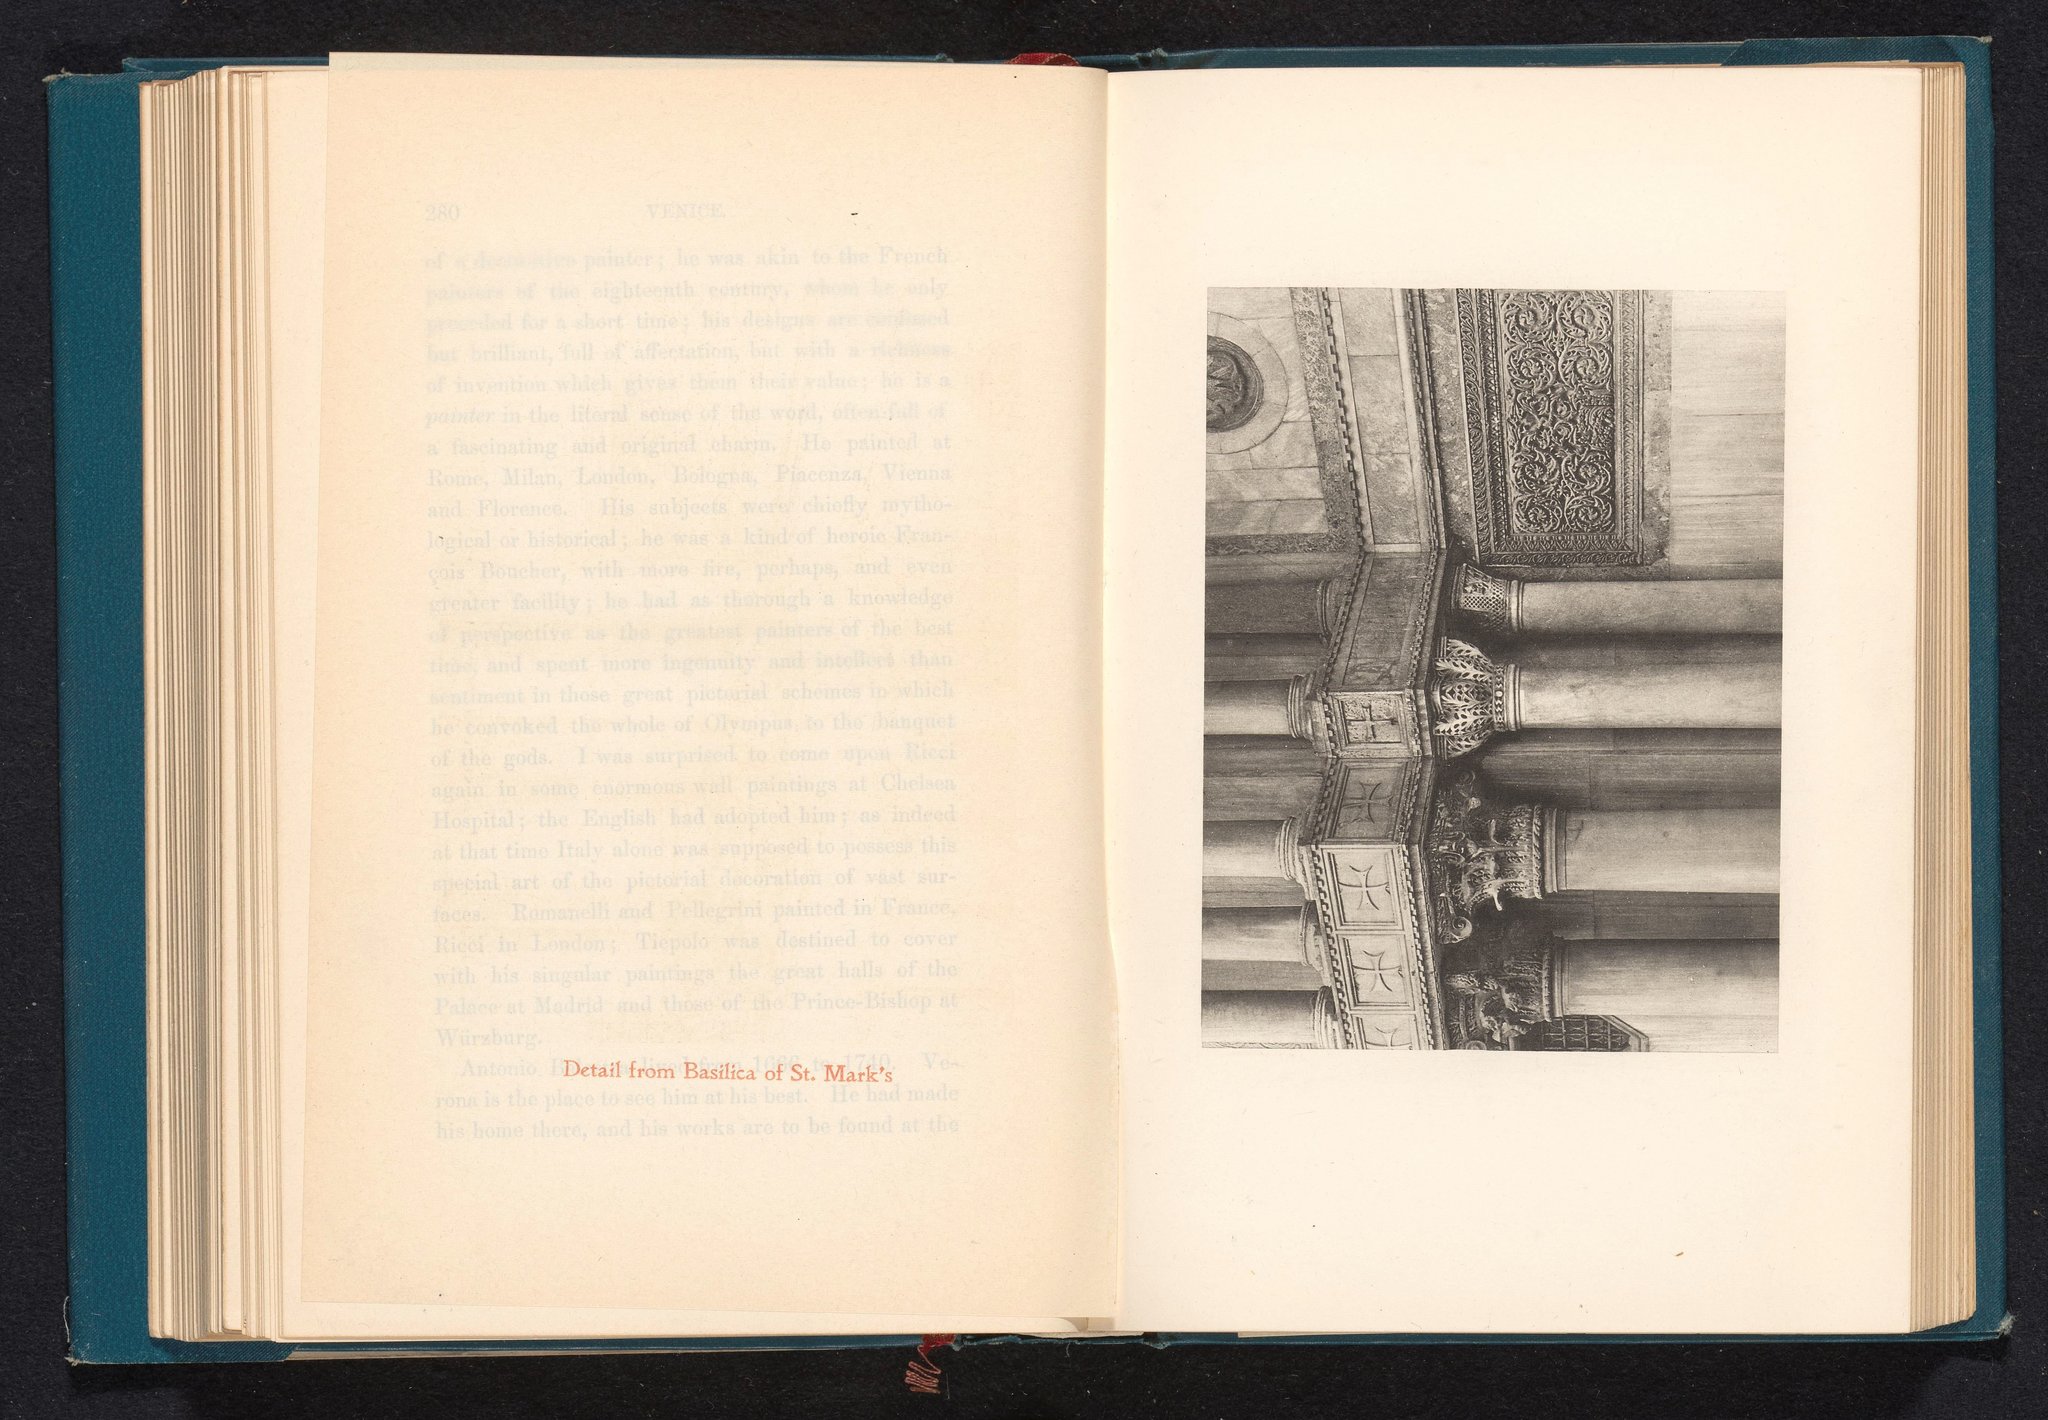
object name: page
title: Deel van de gevel van de San Marco te Venetië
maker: Anonymous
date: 1882-1892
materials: paper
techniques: photoaquatint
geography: san marco square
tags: palace, church (exterior)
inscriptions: title: ‘Detail from Basilica of St. Mark's’